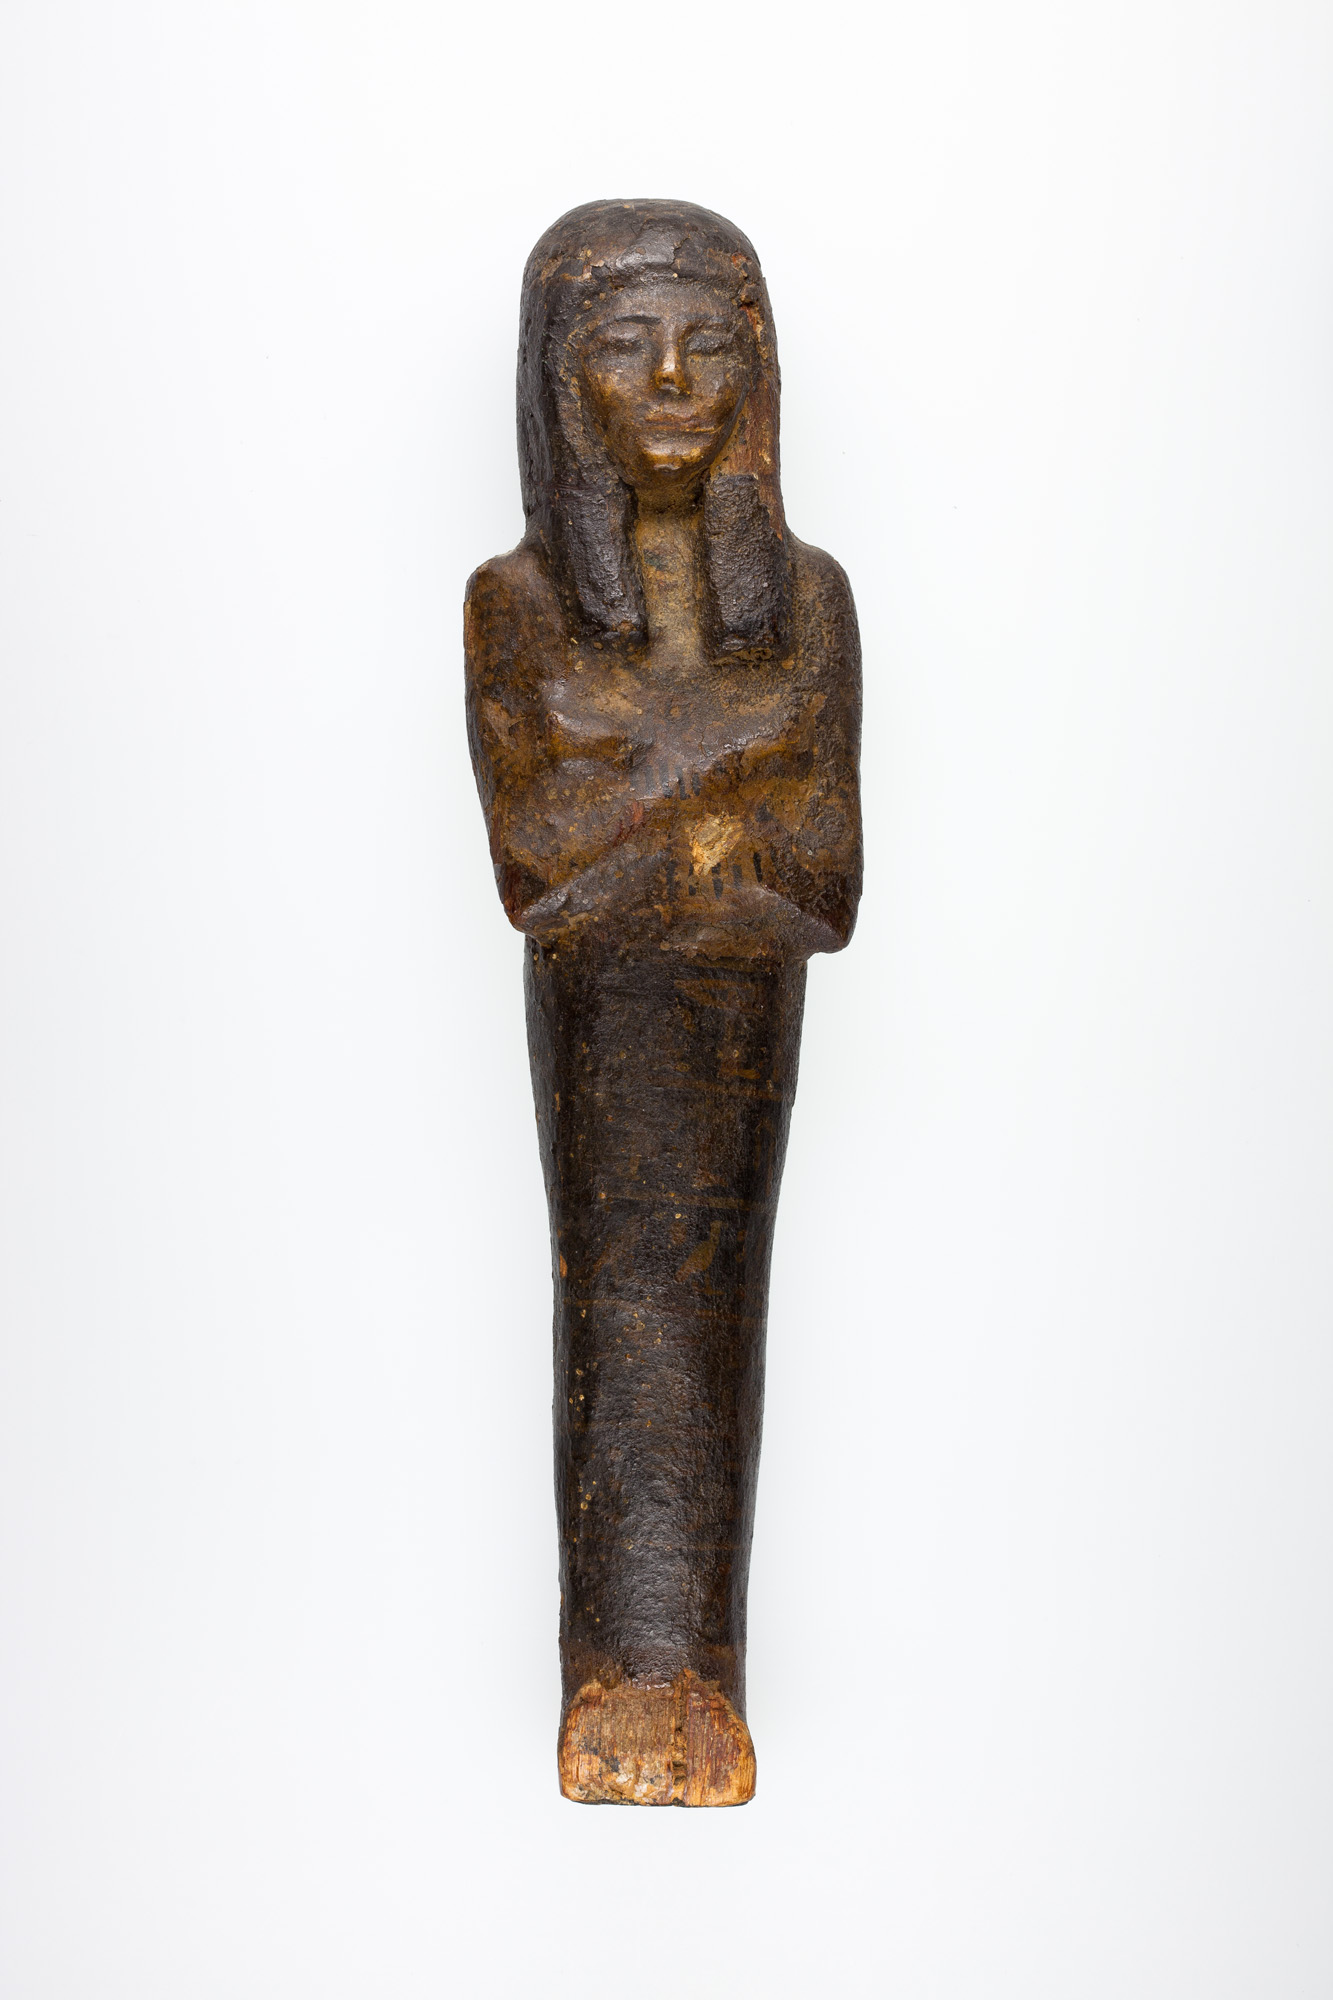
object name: shabti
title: Shabti with horizontal bands of inscription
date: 1295-1070 BCE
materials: paint, plaster, wood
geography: egypt